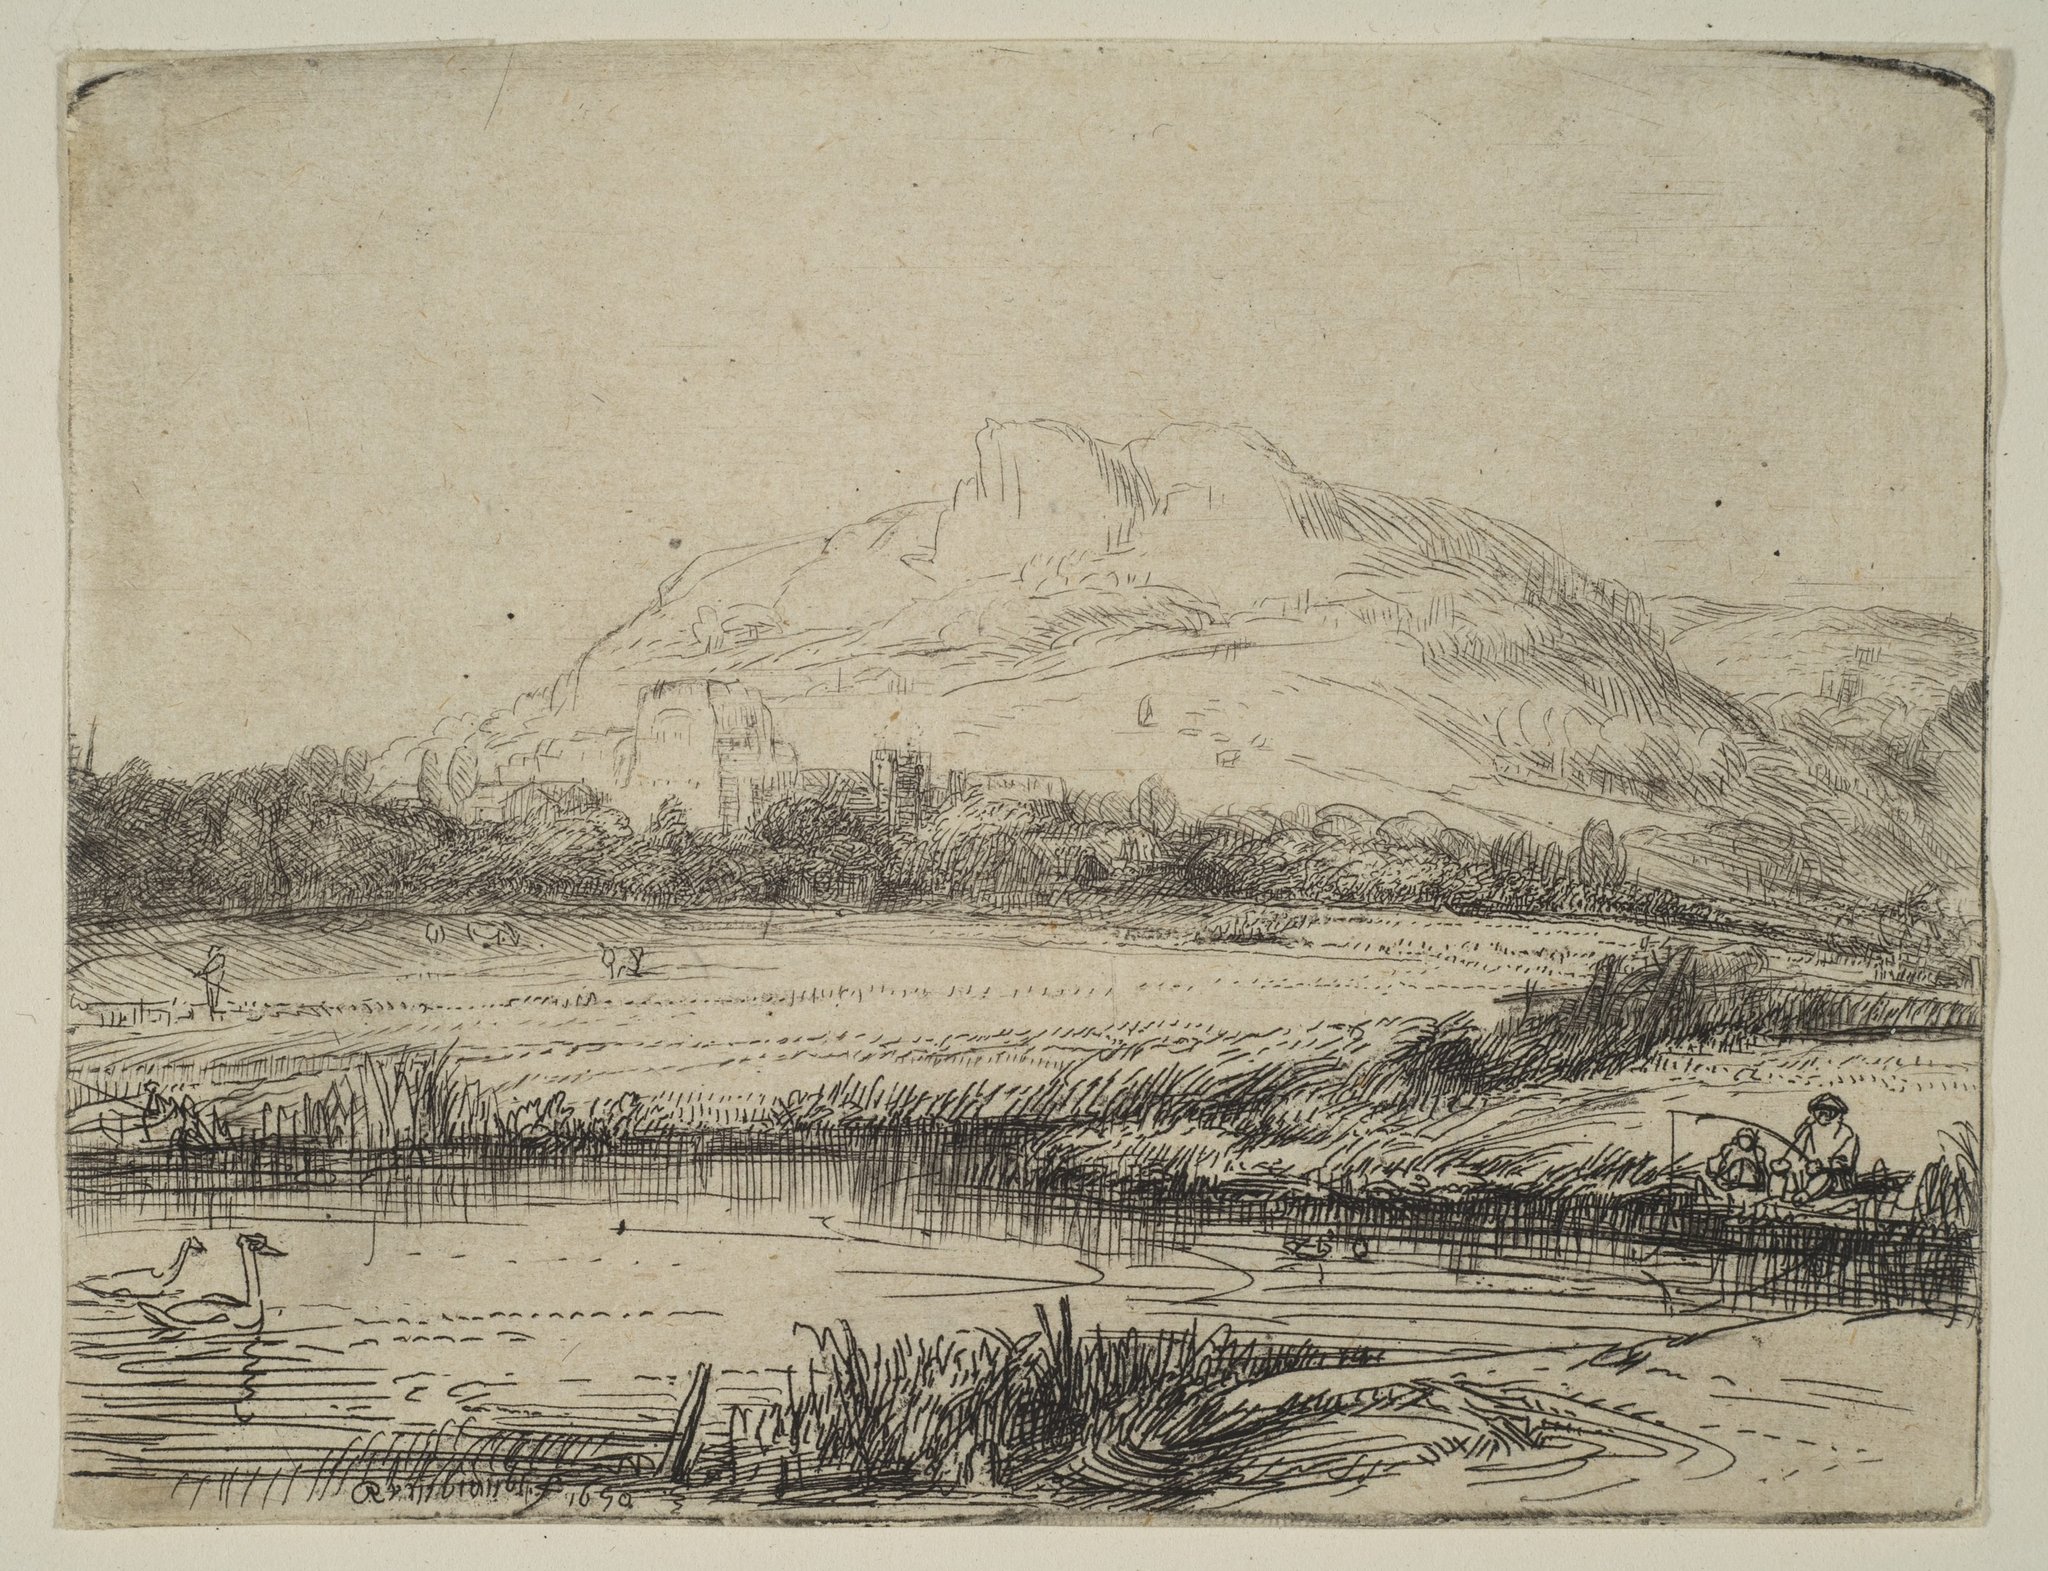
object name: print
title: Canal with an Angler and Two Swans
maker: rembrandt van rijn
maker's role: artist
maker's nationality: dutch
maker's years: 1606-1669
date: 1650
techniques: drypoint, etching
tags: fishing,canals,landscapes